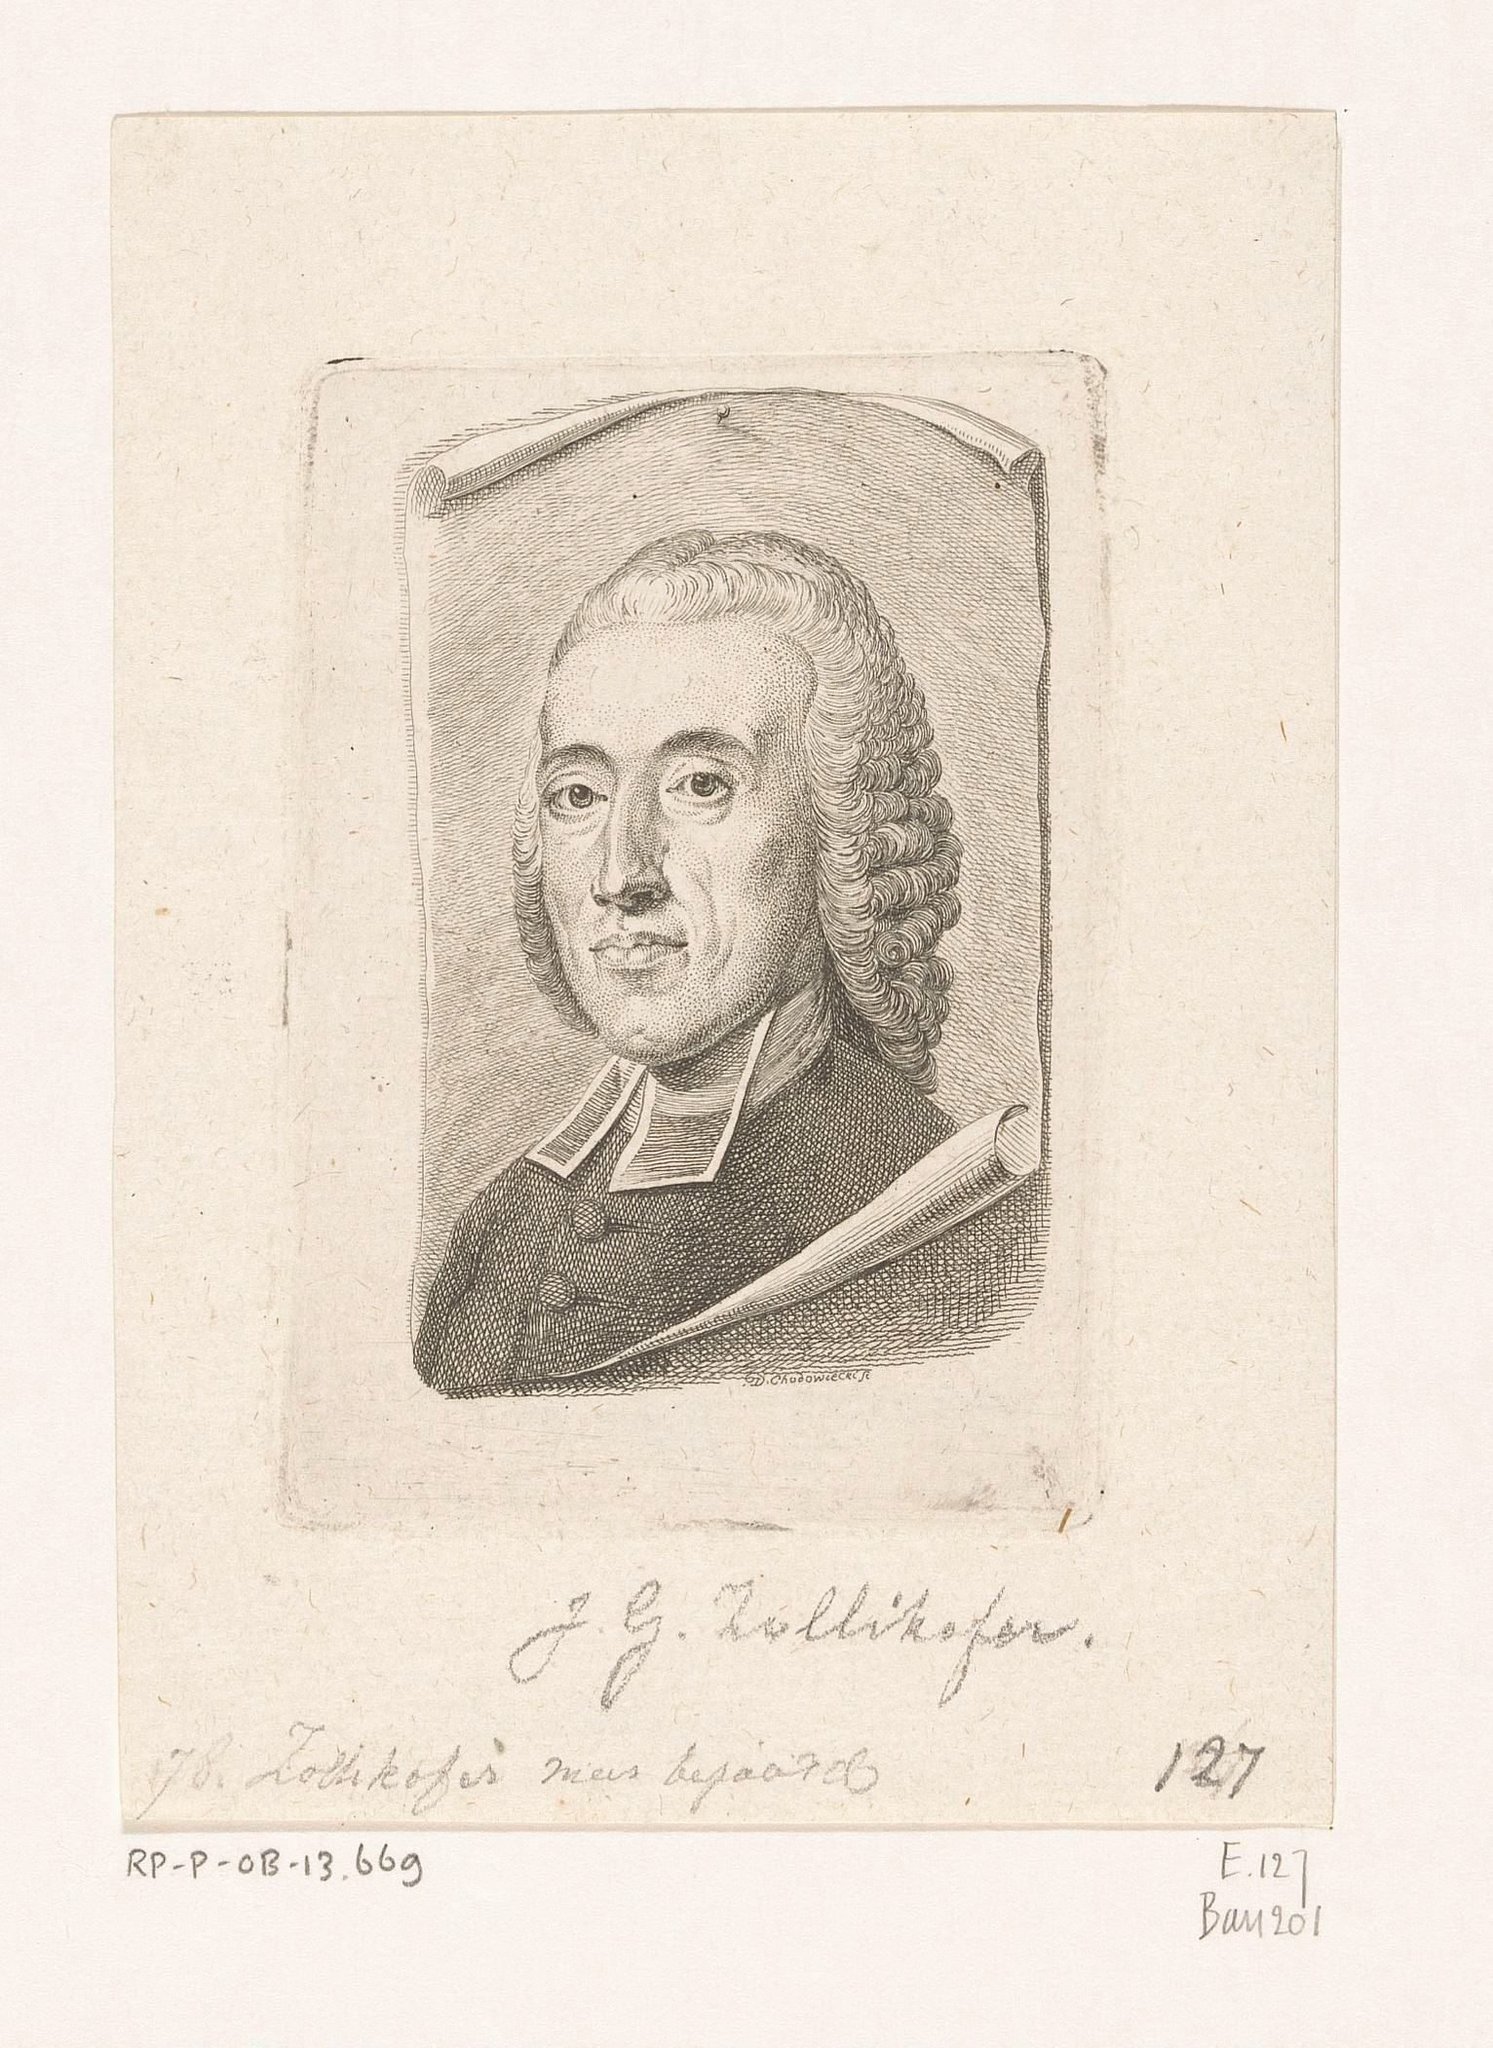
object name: print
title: Portret van Georg Joachim Zollikofer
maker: daniel nikolaus chodowiecki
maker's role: draughtsman, print maker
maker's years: 1726-1801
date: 1775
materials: paper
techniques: etching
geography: berlin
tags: johann caspar lavater, historical persons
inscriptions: collector's mark: Lugt 2228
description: Ook gebruikt in: Lavater, Johann Kaspar. Physiognomische Fragmente zur Beförderung der Menschenkenntniß und Menschenliebe. Leipzig en Winterthur: erven Weidmann en Reich en Heinrich Steiner en Compagnie, 1775-1778. De prentmaker vervaardigde dit portret op basis van een tekening van een onbekende kunstenaar.